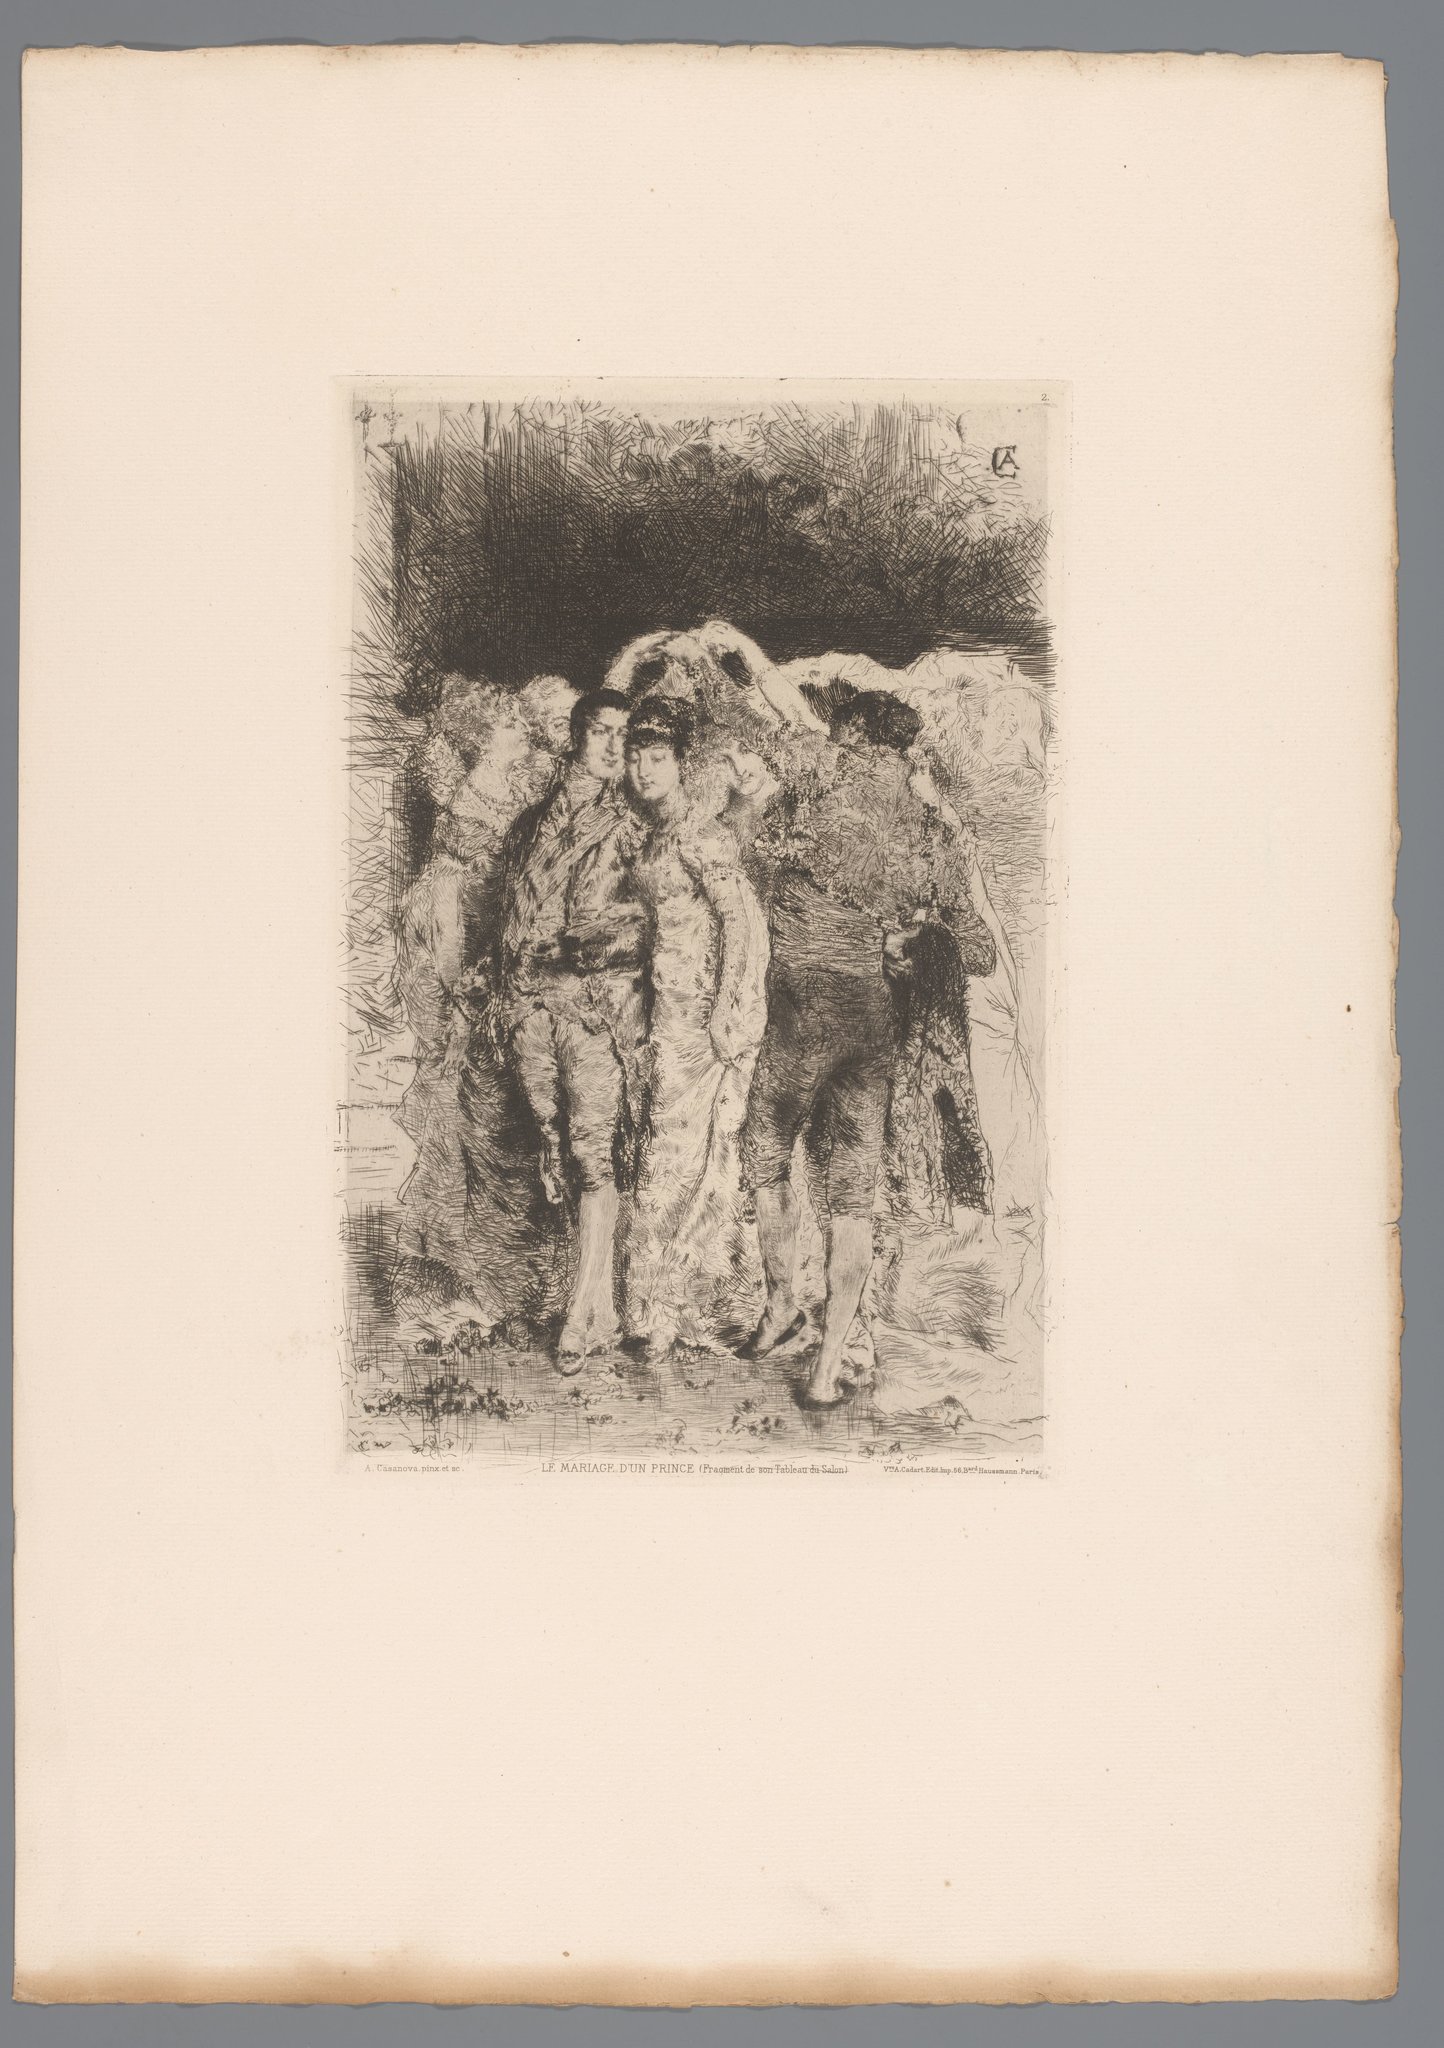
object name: print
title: Le mariage d'un prince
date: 1880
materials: paper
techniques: drypoint, etching, intaglio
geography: paris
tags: prince, betrothal and marriage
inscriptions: collector's mark: ‘AFE v S’, collector's mark: Lugt 2760, watermark, collector's mark: Lugt 2228